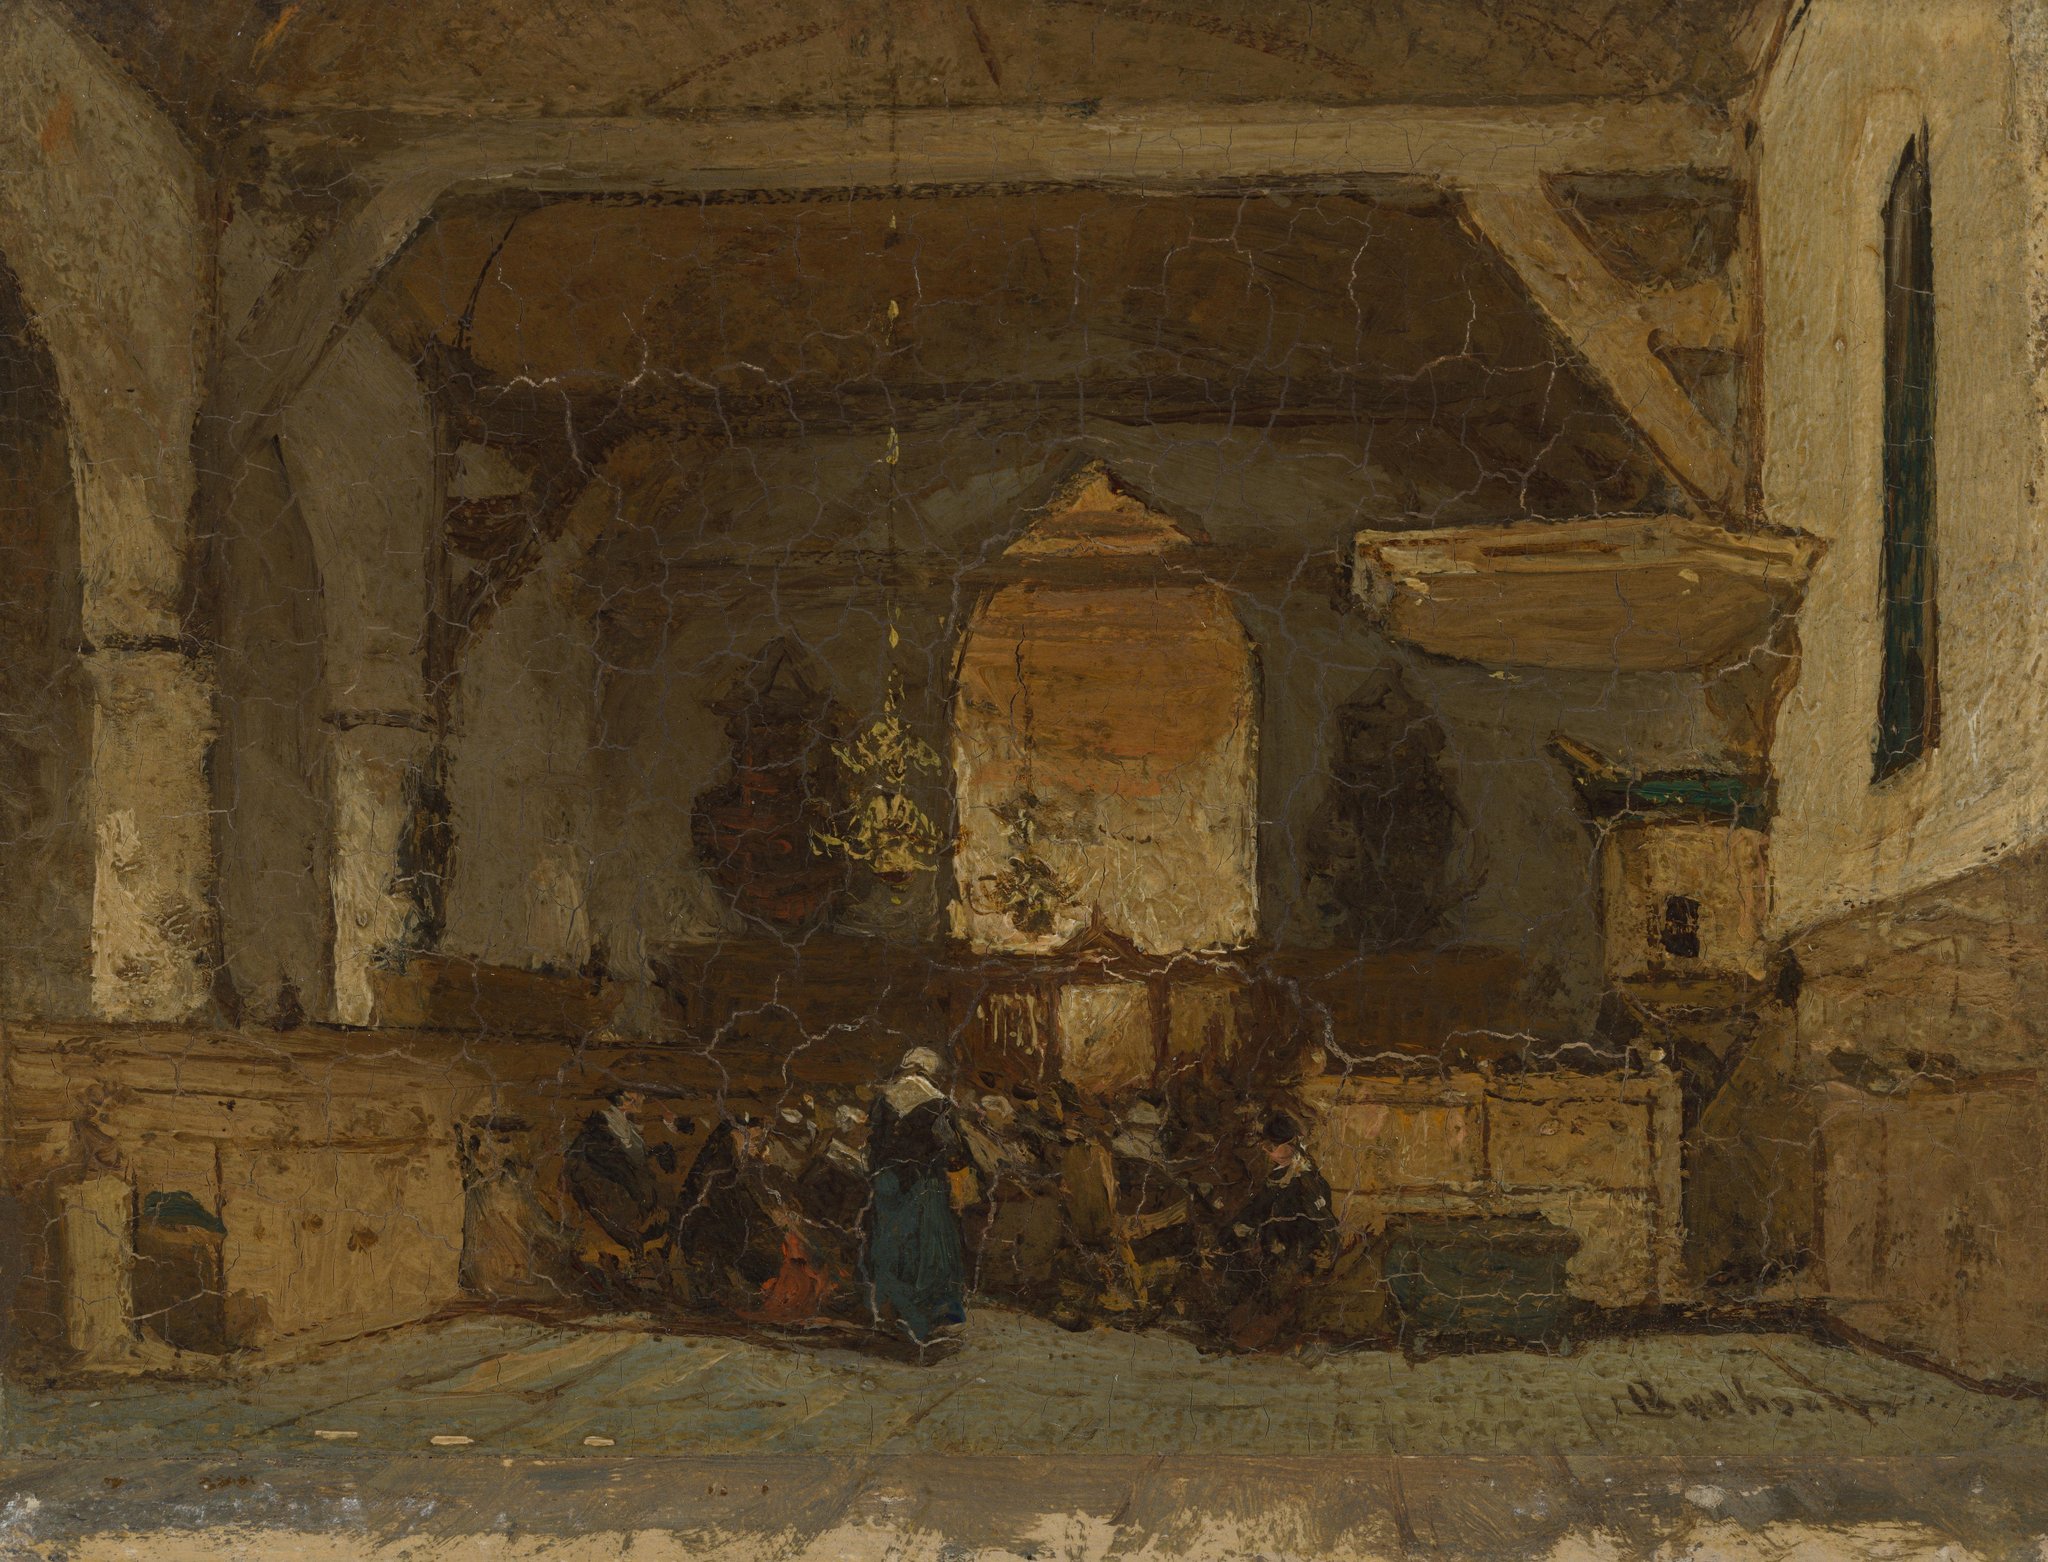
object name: painting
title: Interior of the Church in Maasland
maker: johannes bosboom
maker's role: draughtsman, painter, print maker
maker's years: 1817-1891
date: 1870-1875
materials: oil, panel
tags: interior of church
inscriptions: signature: ‘Bosboom’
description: Interieur van de kerk te Maasland. Een groep zittende figuren voor de preekstoel.